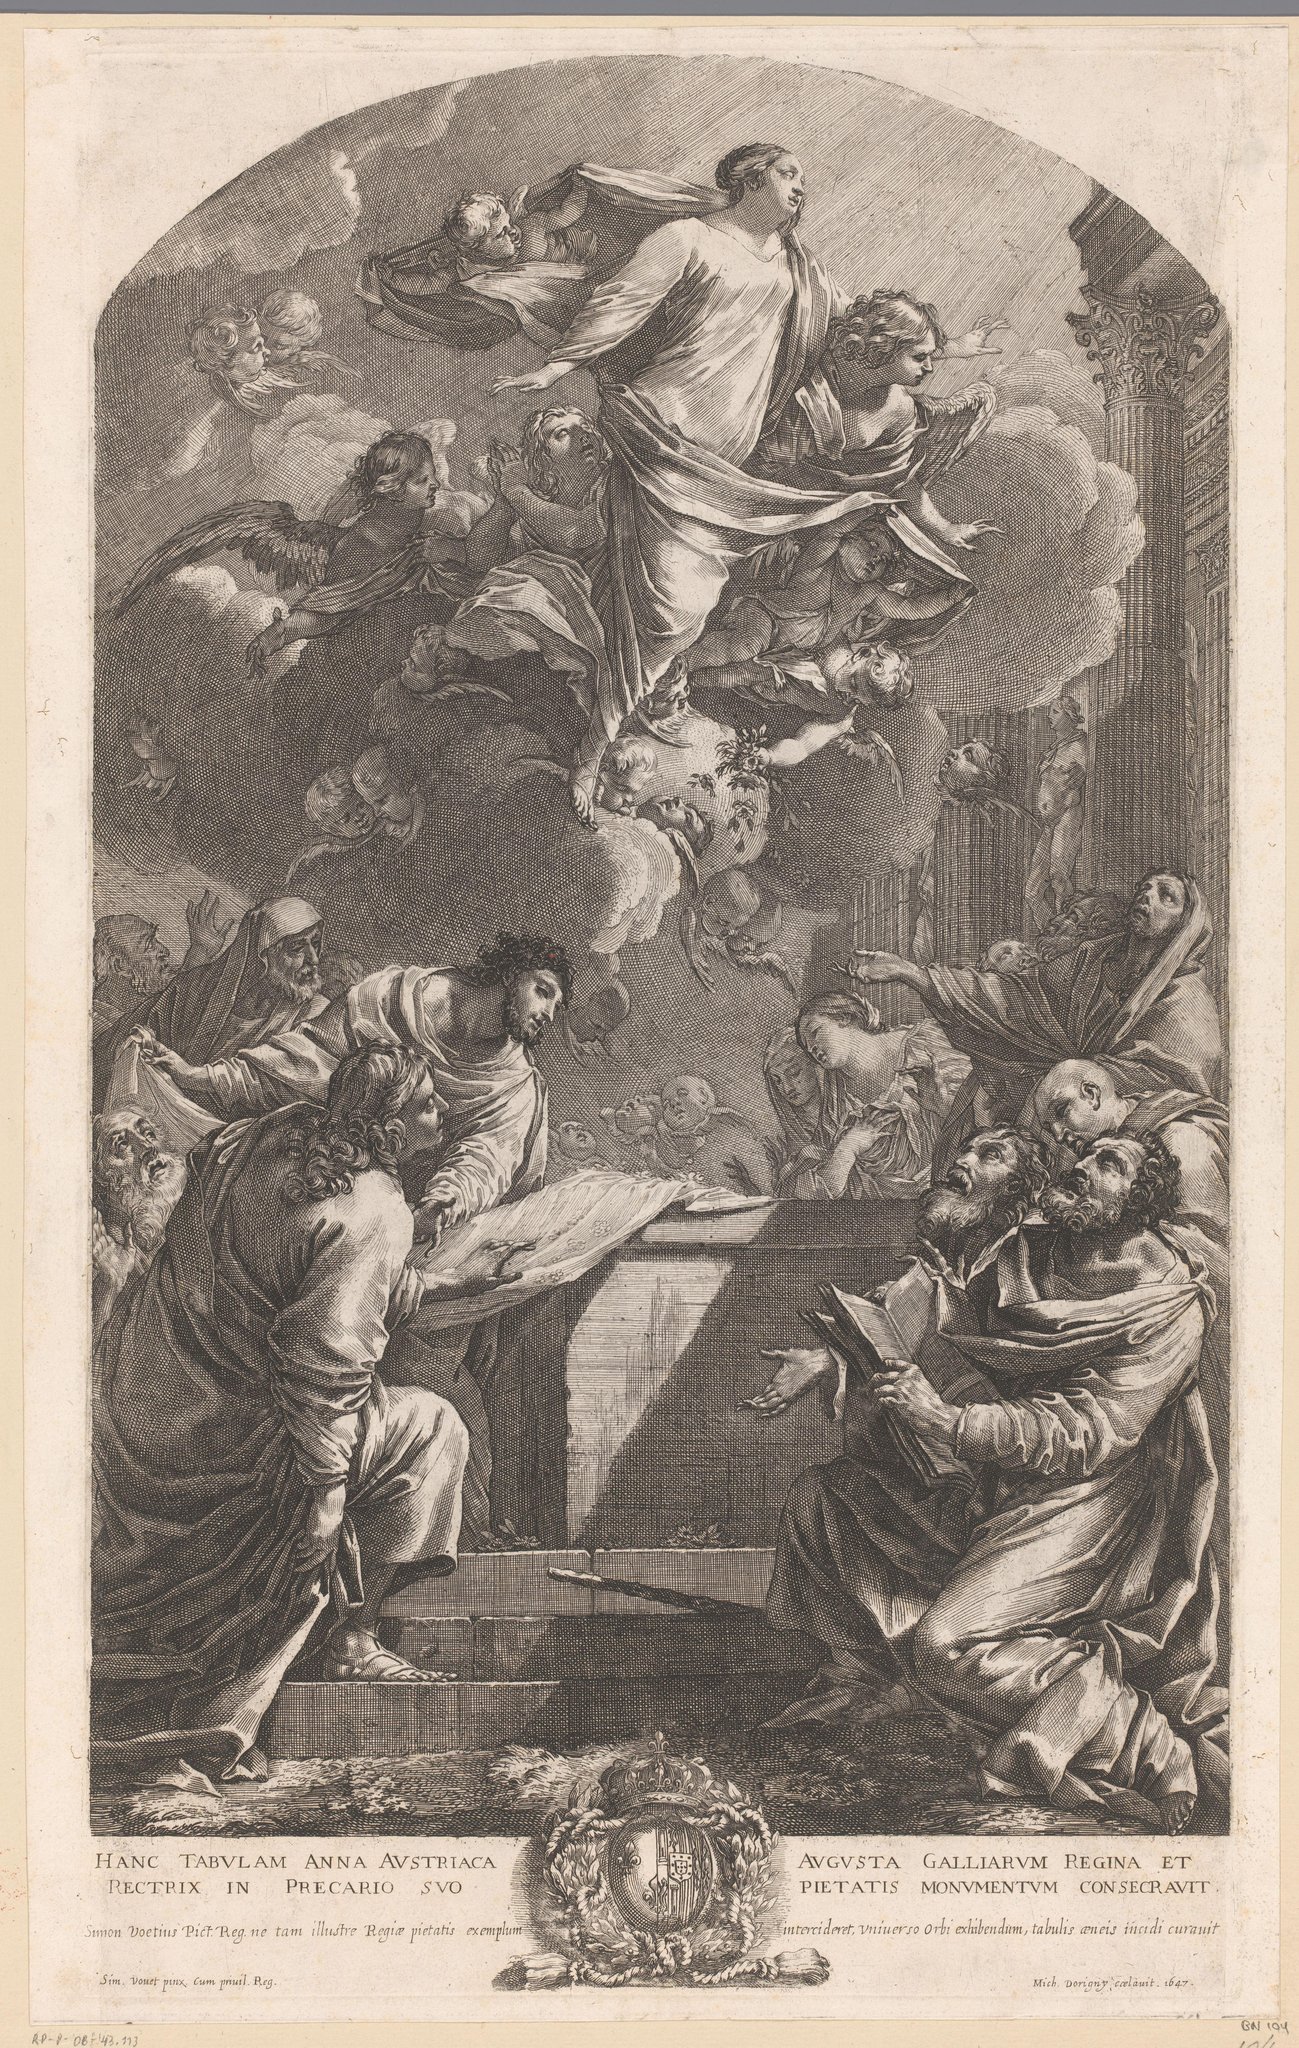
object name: print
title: Hemelvaart van Maria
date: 1647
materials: paper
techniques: engraving, etching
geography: france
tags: the assumption of mary ('assumptio corporis'): she is borne into heaven by angels, armorial bearing, heraldry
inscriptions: collector's mark: Lugt 240